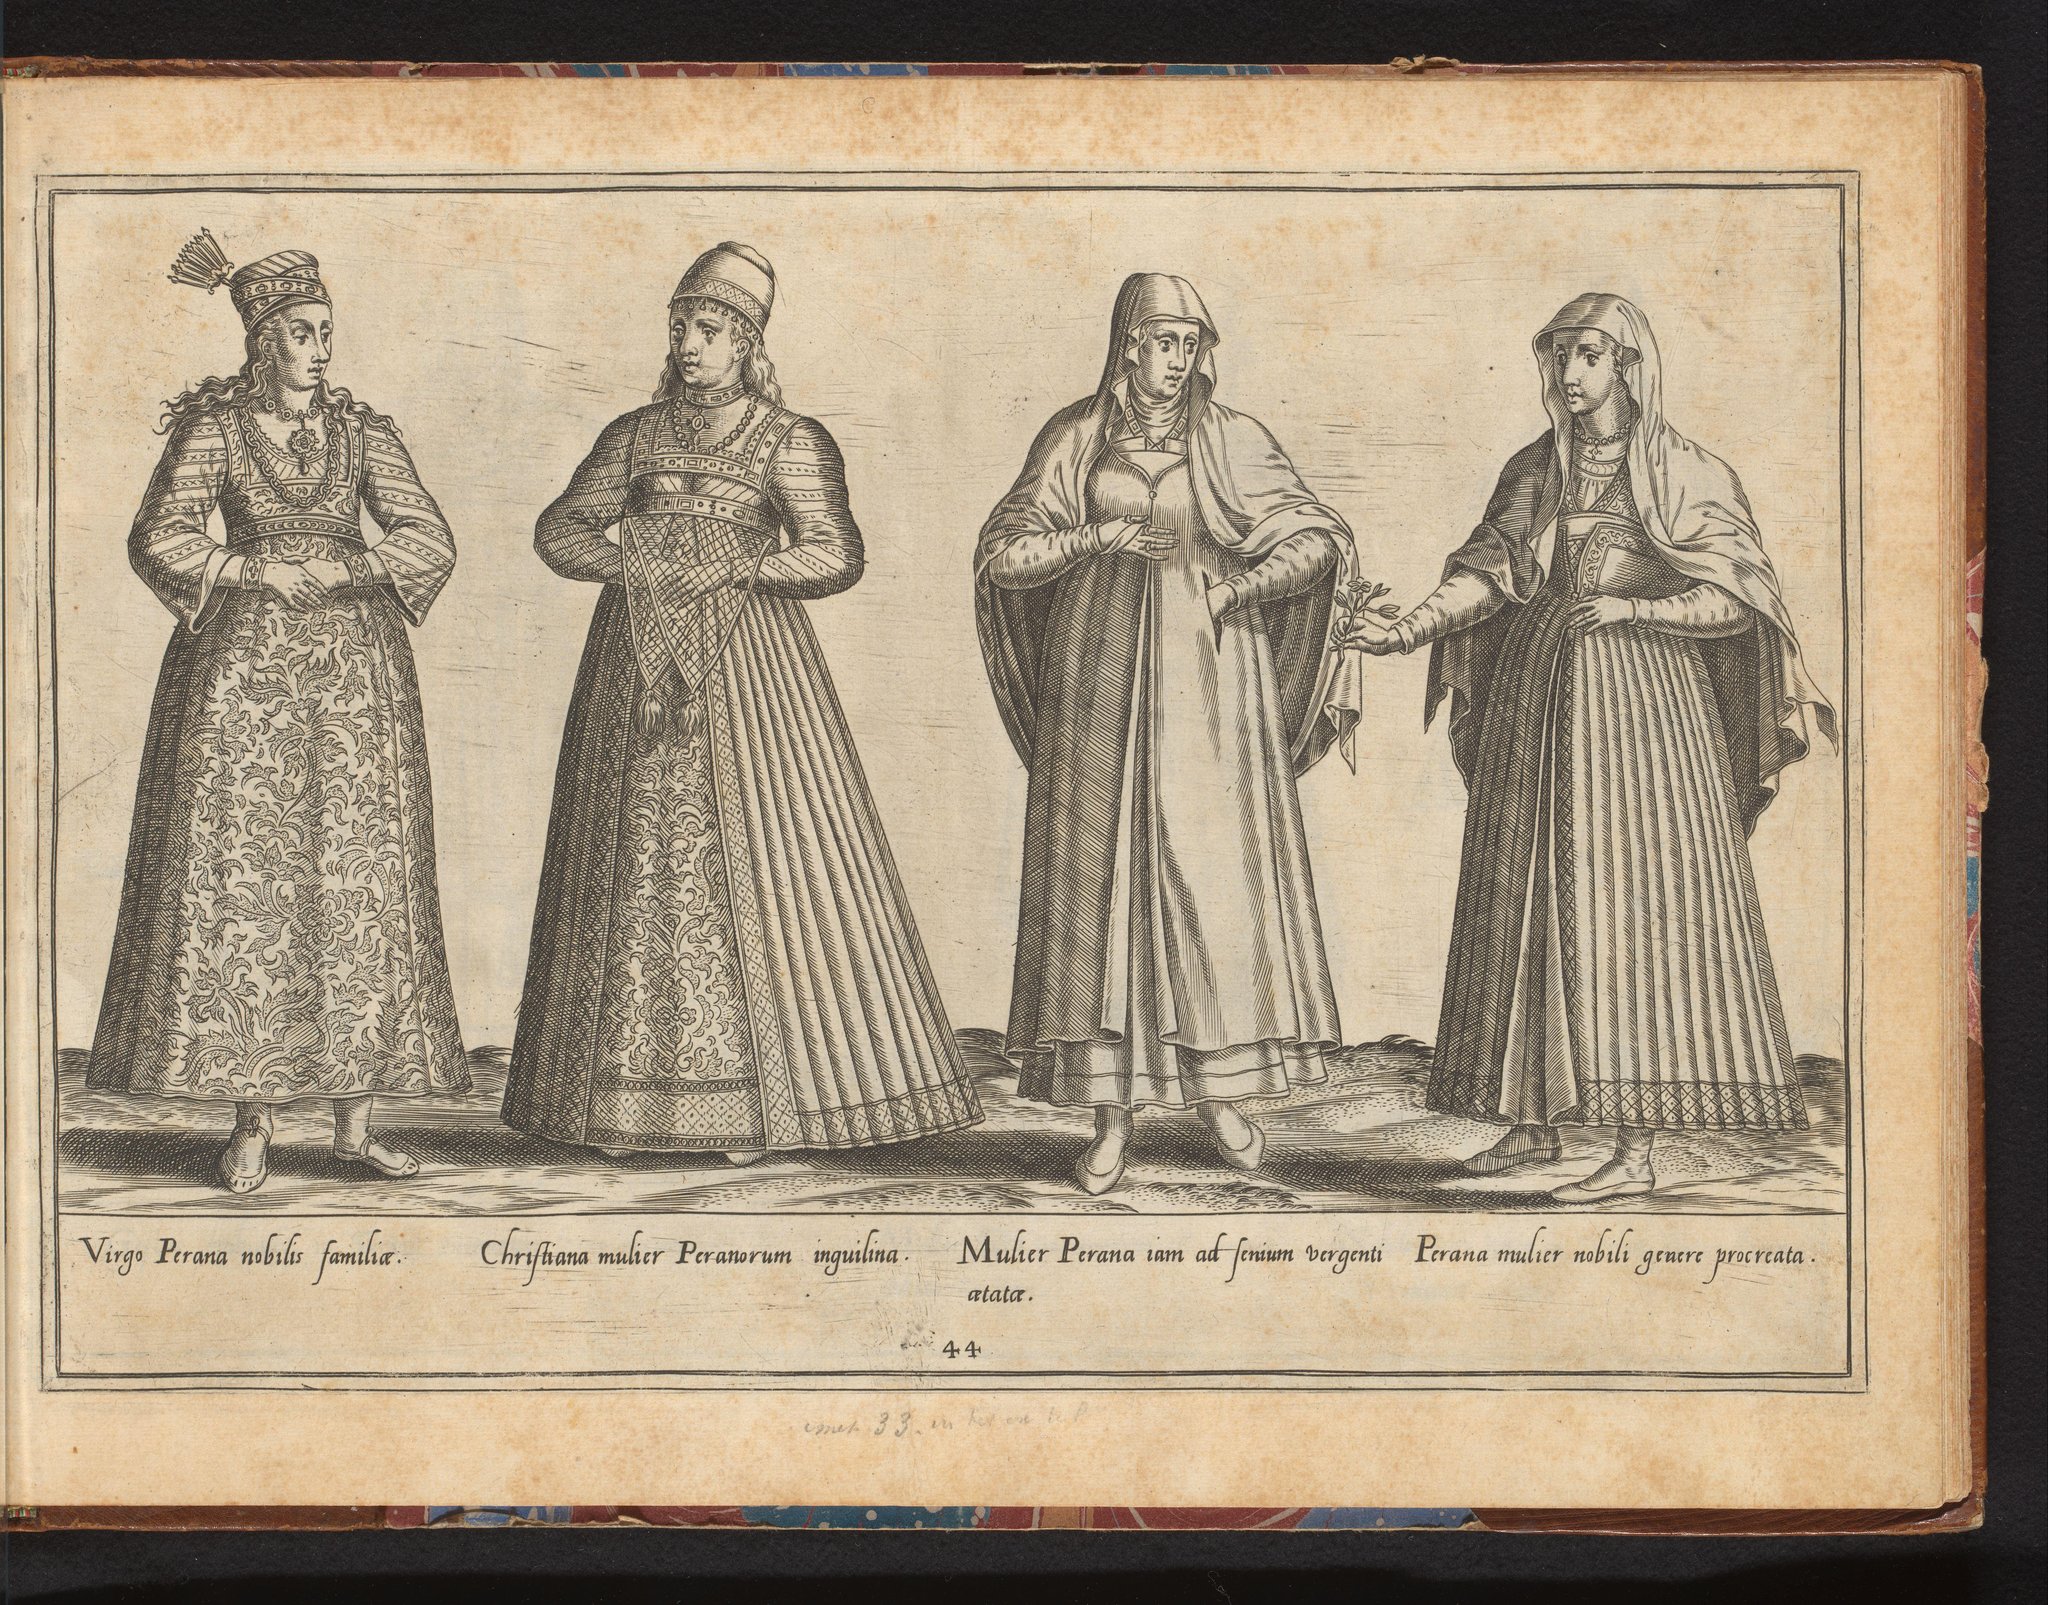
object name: costume print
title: Vier Perzische vrouwen, gekleed volgens de mode van ca. 1580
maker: abraham de bruyn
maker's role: print maker, publisher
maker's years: 1540-1587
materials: paper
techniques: engraving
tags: asiatic races and peoples: persians (+ costume)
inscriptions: number: ‘44’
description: Prent uit het boek 'Omnium pene Europae, Asiae, Aphricae atque Americae gentium habitus...', 1581. De prent maakt deel uit van een album.